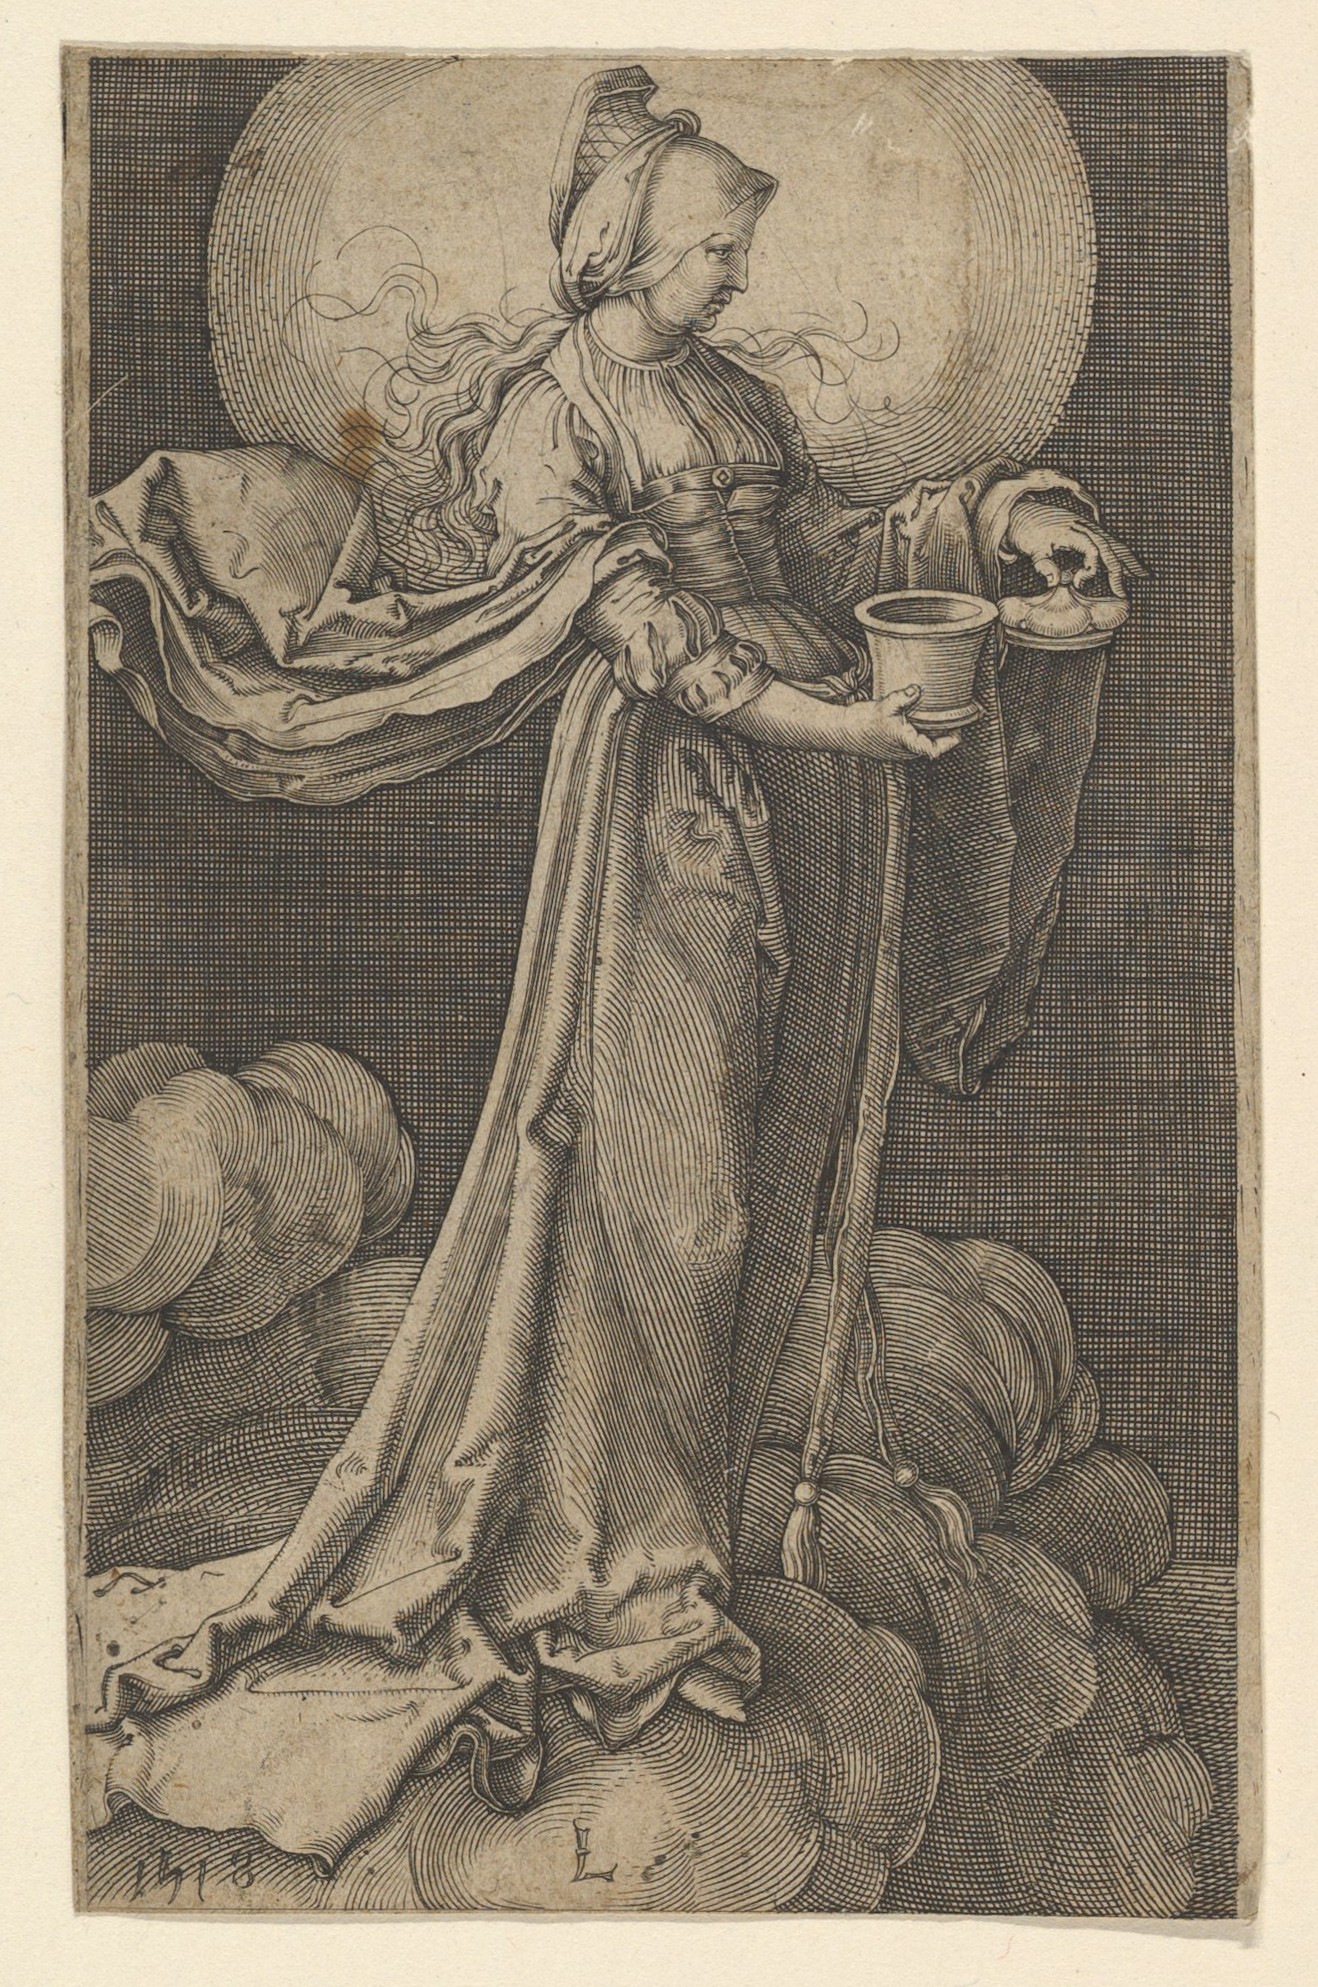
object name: print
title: St. Mary Magdalene in the Clouds (copy)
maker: lucas van leyden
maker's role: artist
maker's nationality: netherlandish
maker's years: 1494-1533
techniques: engraving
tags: women,mary magdalene